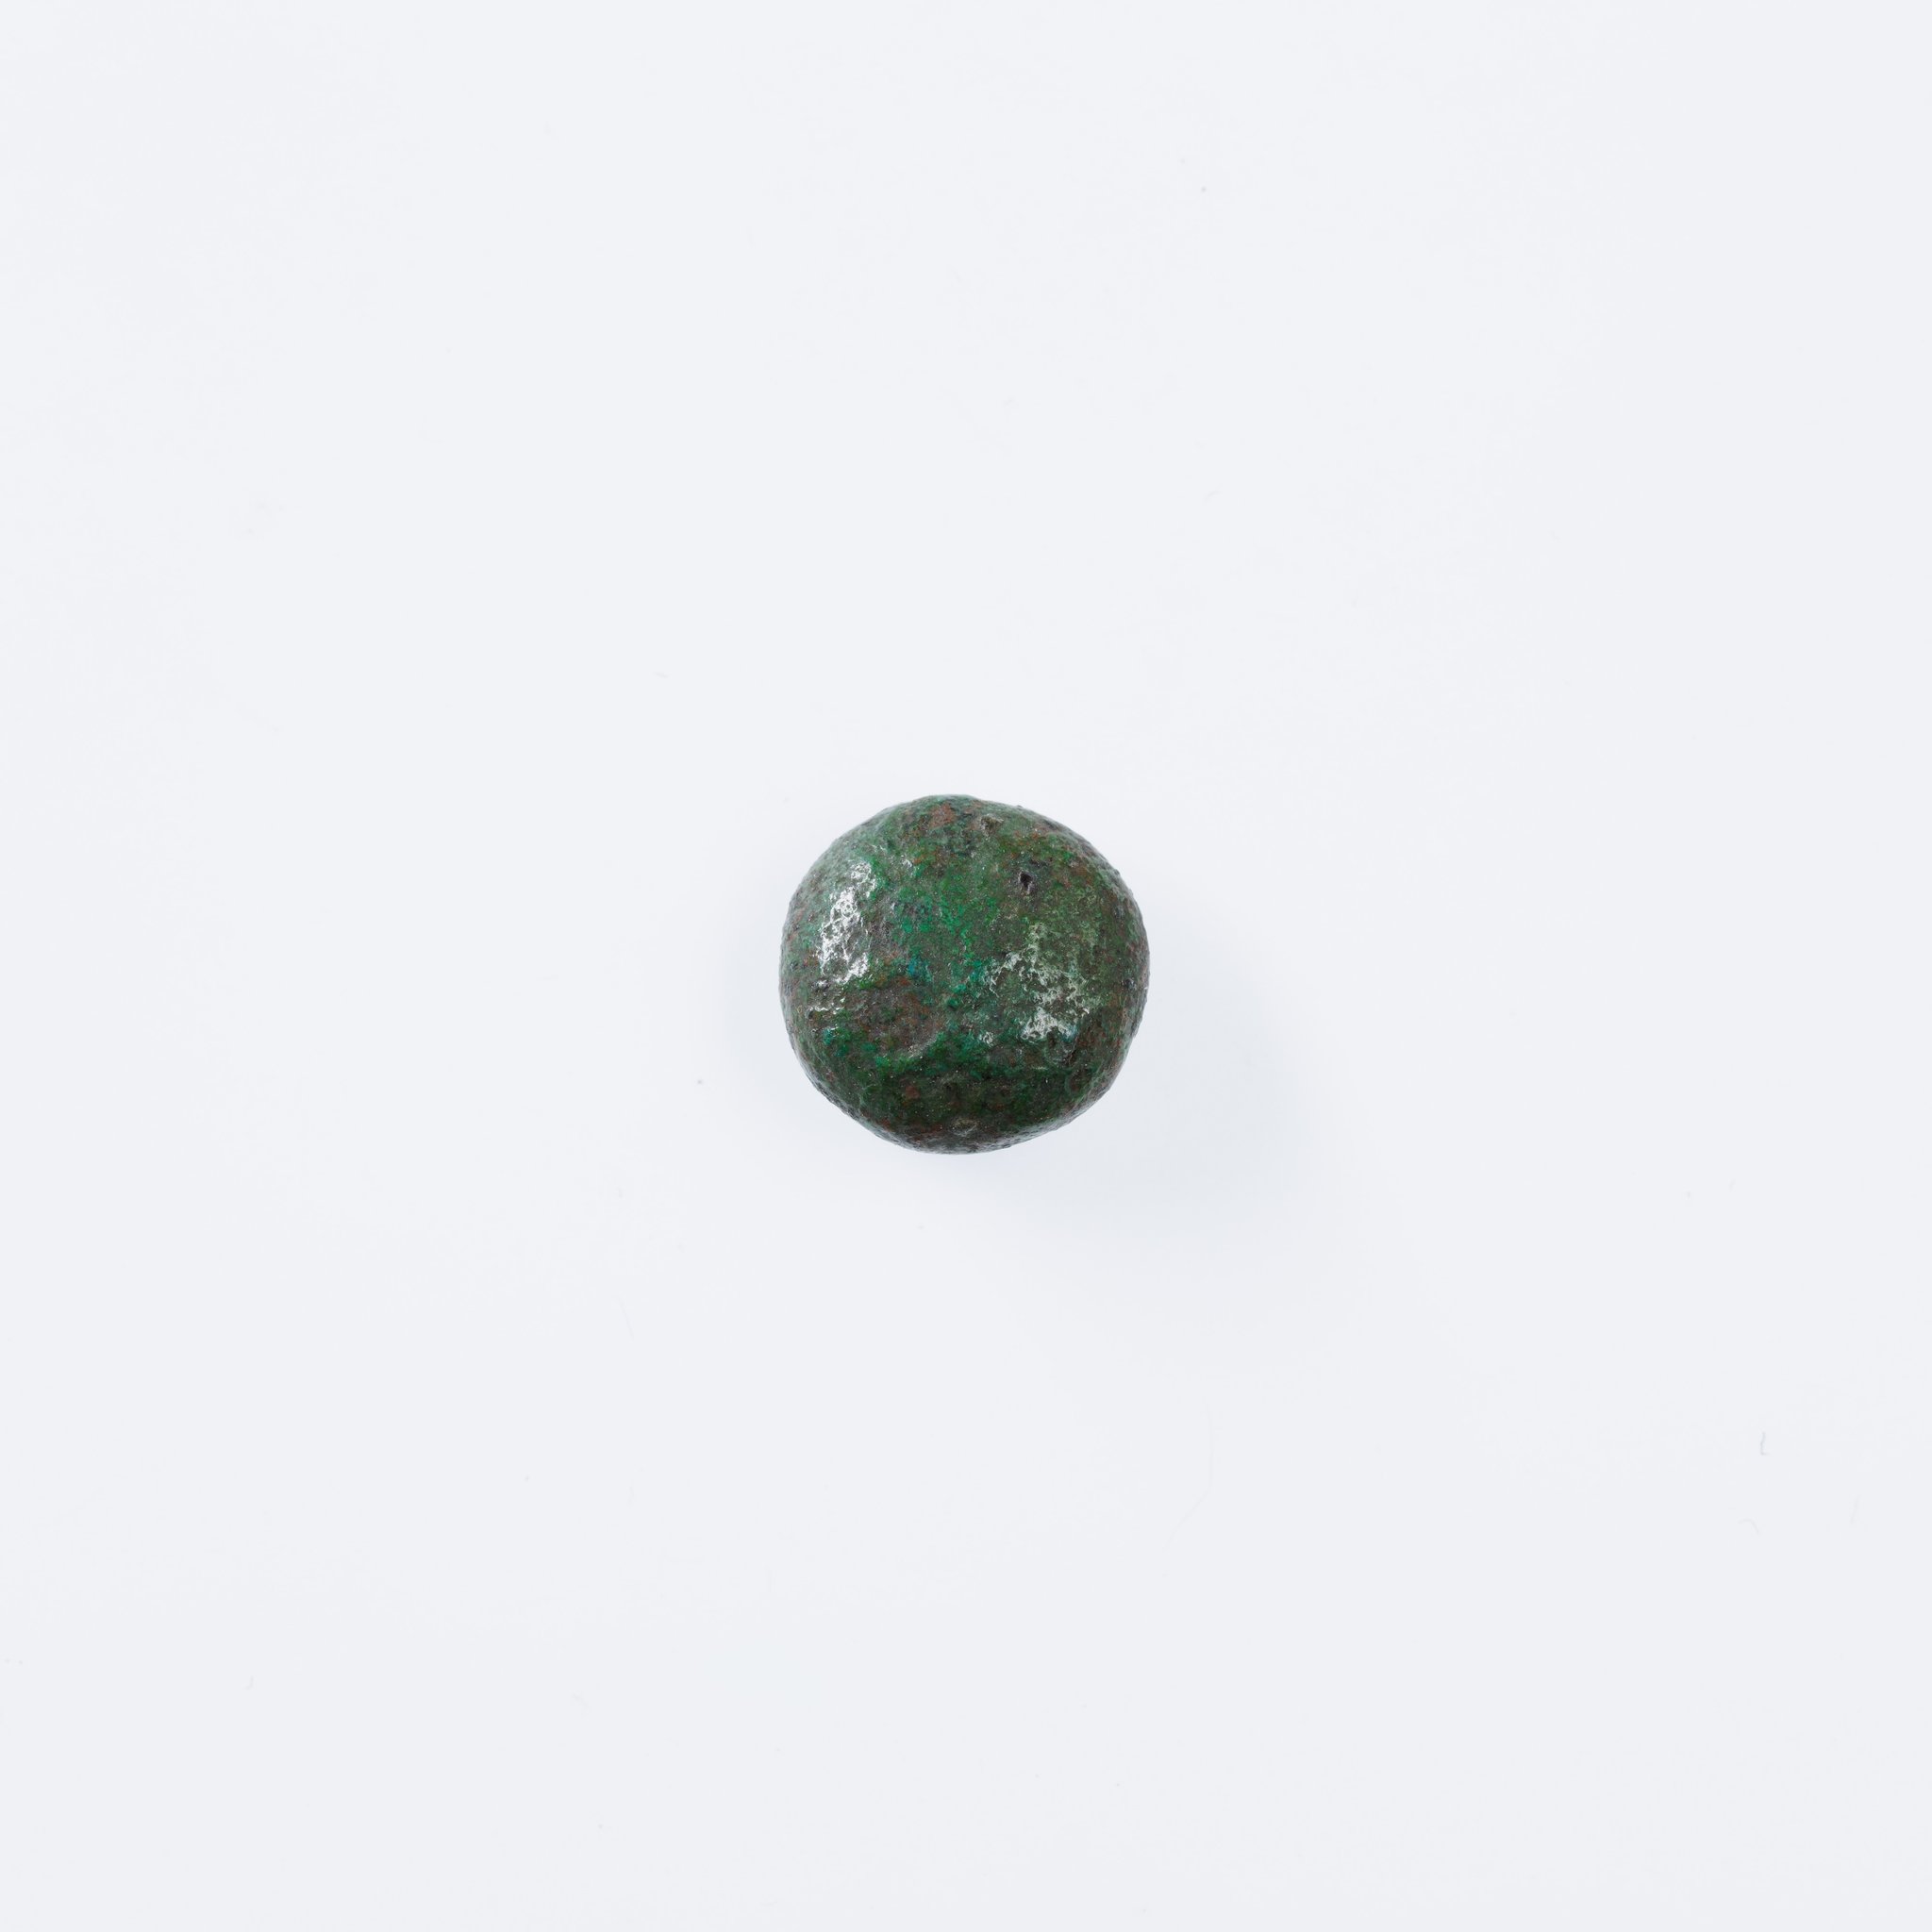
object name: weight, 1 4 kedet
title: Weight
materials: copper alloy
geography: egypt